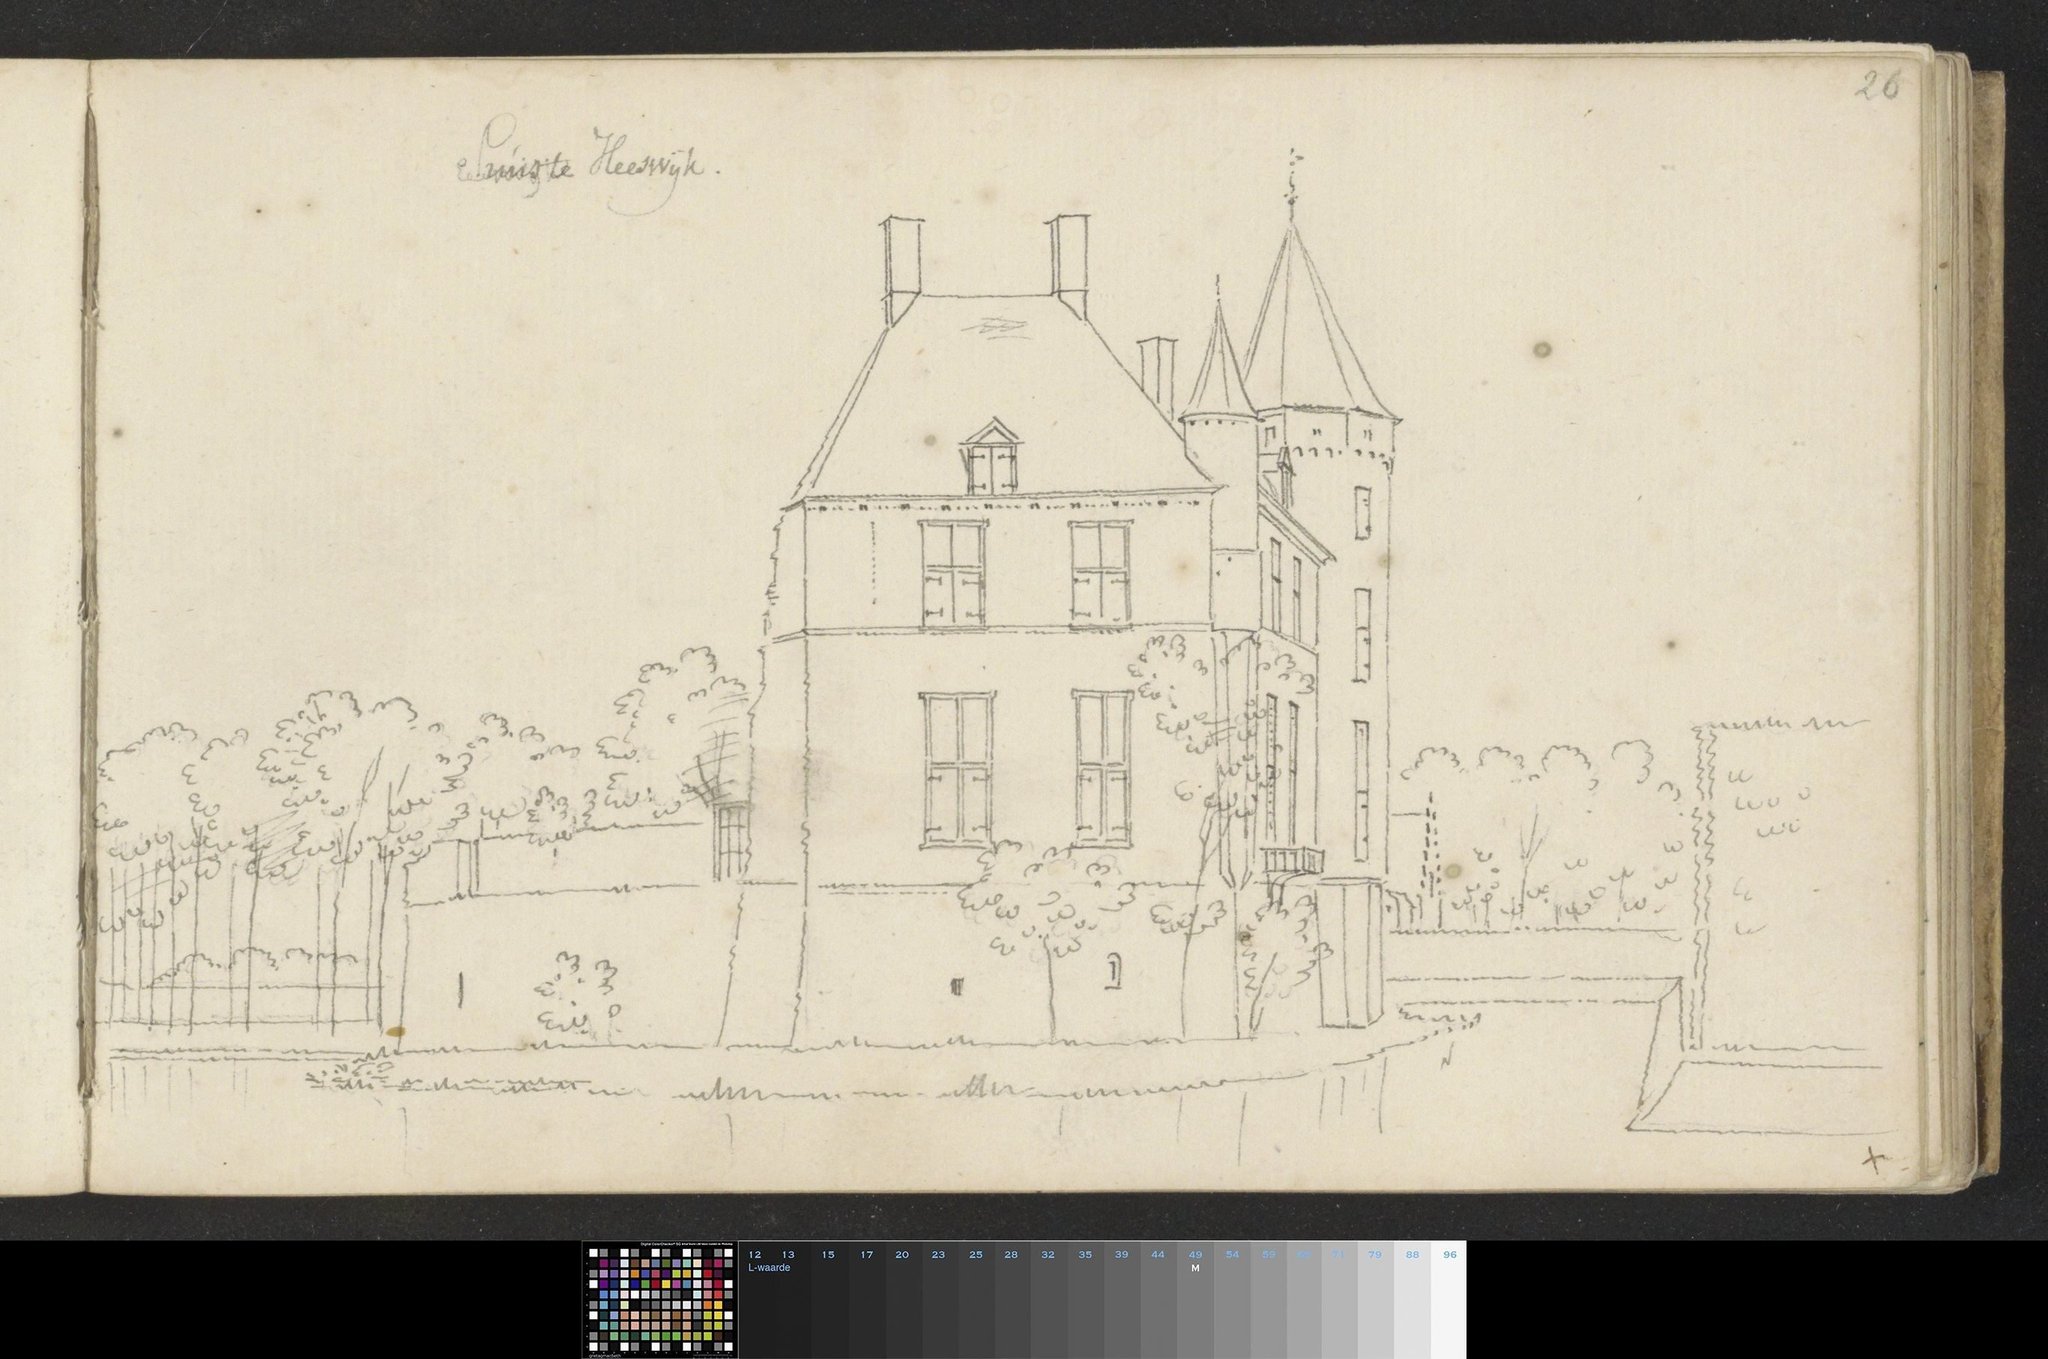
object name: sketchbook leaf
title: Kasteel Heeswijk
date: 1701-1759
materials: ink, paper, pencil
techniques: pen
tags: castle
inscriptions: annotation: ‘huis te Heeswijk’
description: Blad 26 recto uit een schetsboek met 65 bladen.